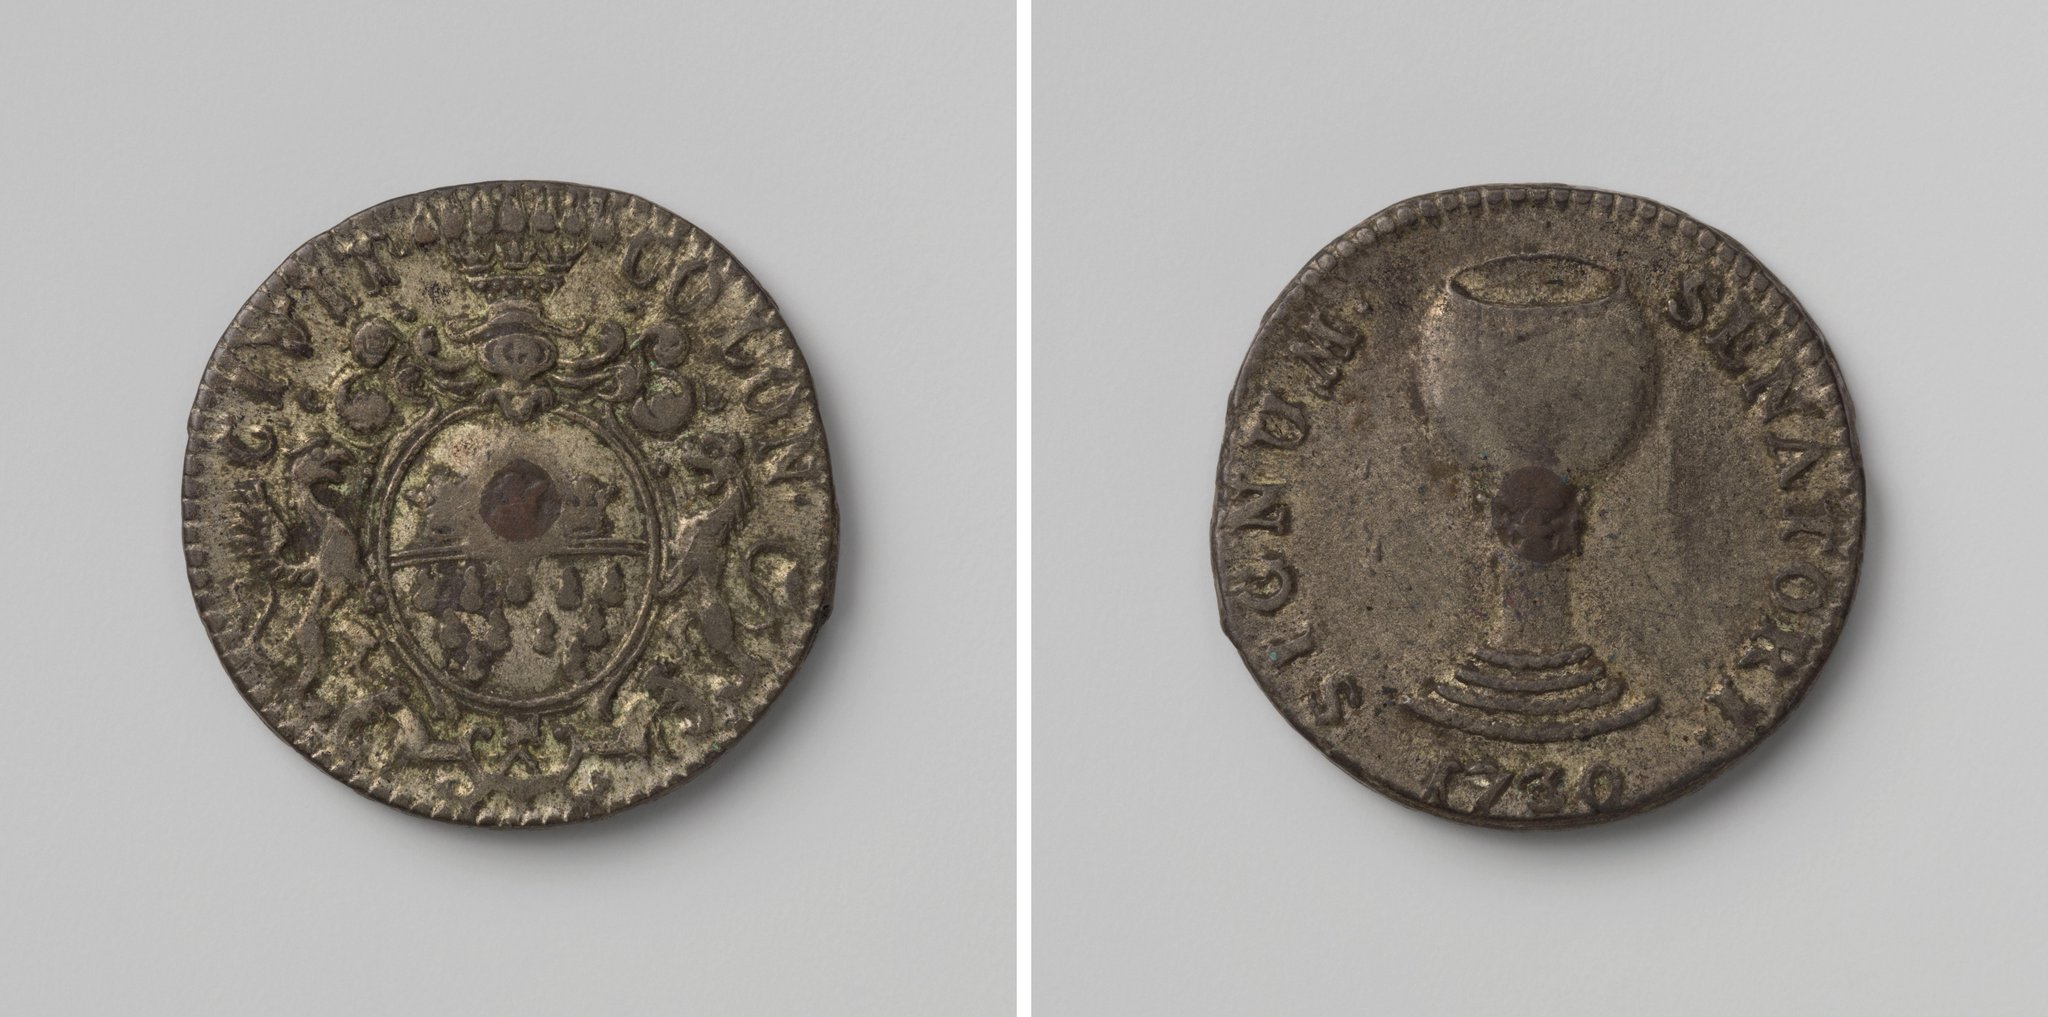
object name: council medal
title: Vroedschapspenning van de stad Keulen, penning uitgereikt aan de leden van de stadsraad recht gevend op een kan bier of wijn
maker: Anonymous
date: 1730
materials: metal alloy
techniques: striking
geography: cologne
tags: cologne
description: Penning. Voorzijde: gehelmd wapenschild, geflankeerd door griffioen en leeuw binnen omschrift. Keerzijde: kelk met op voet een gezichtje binnen omschrift; randschrift